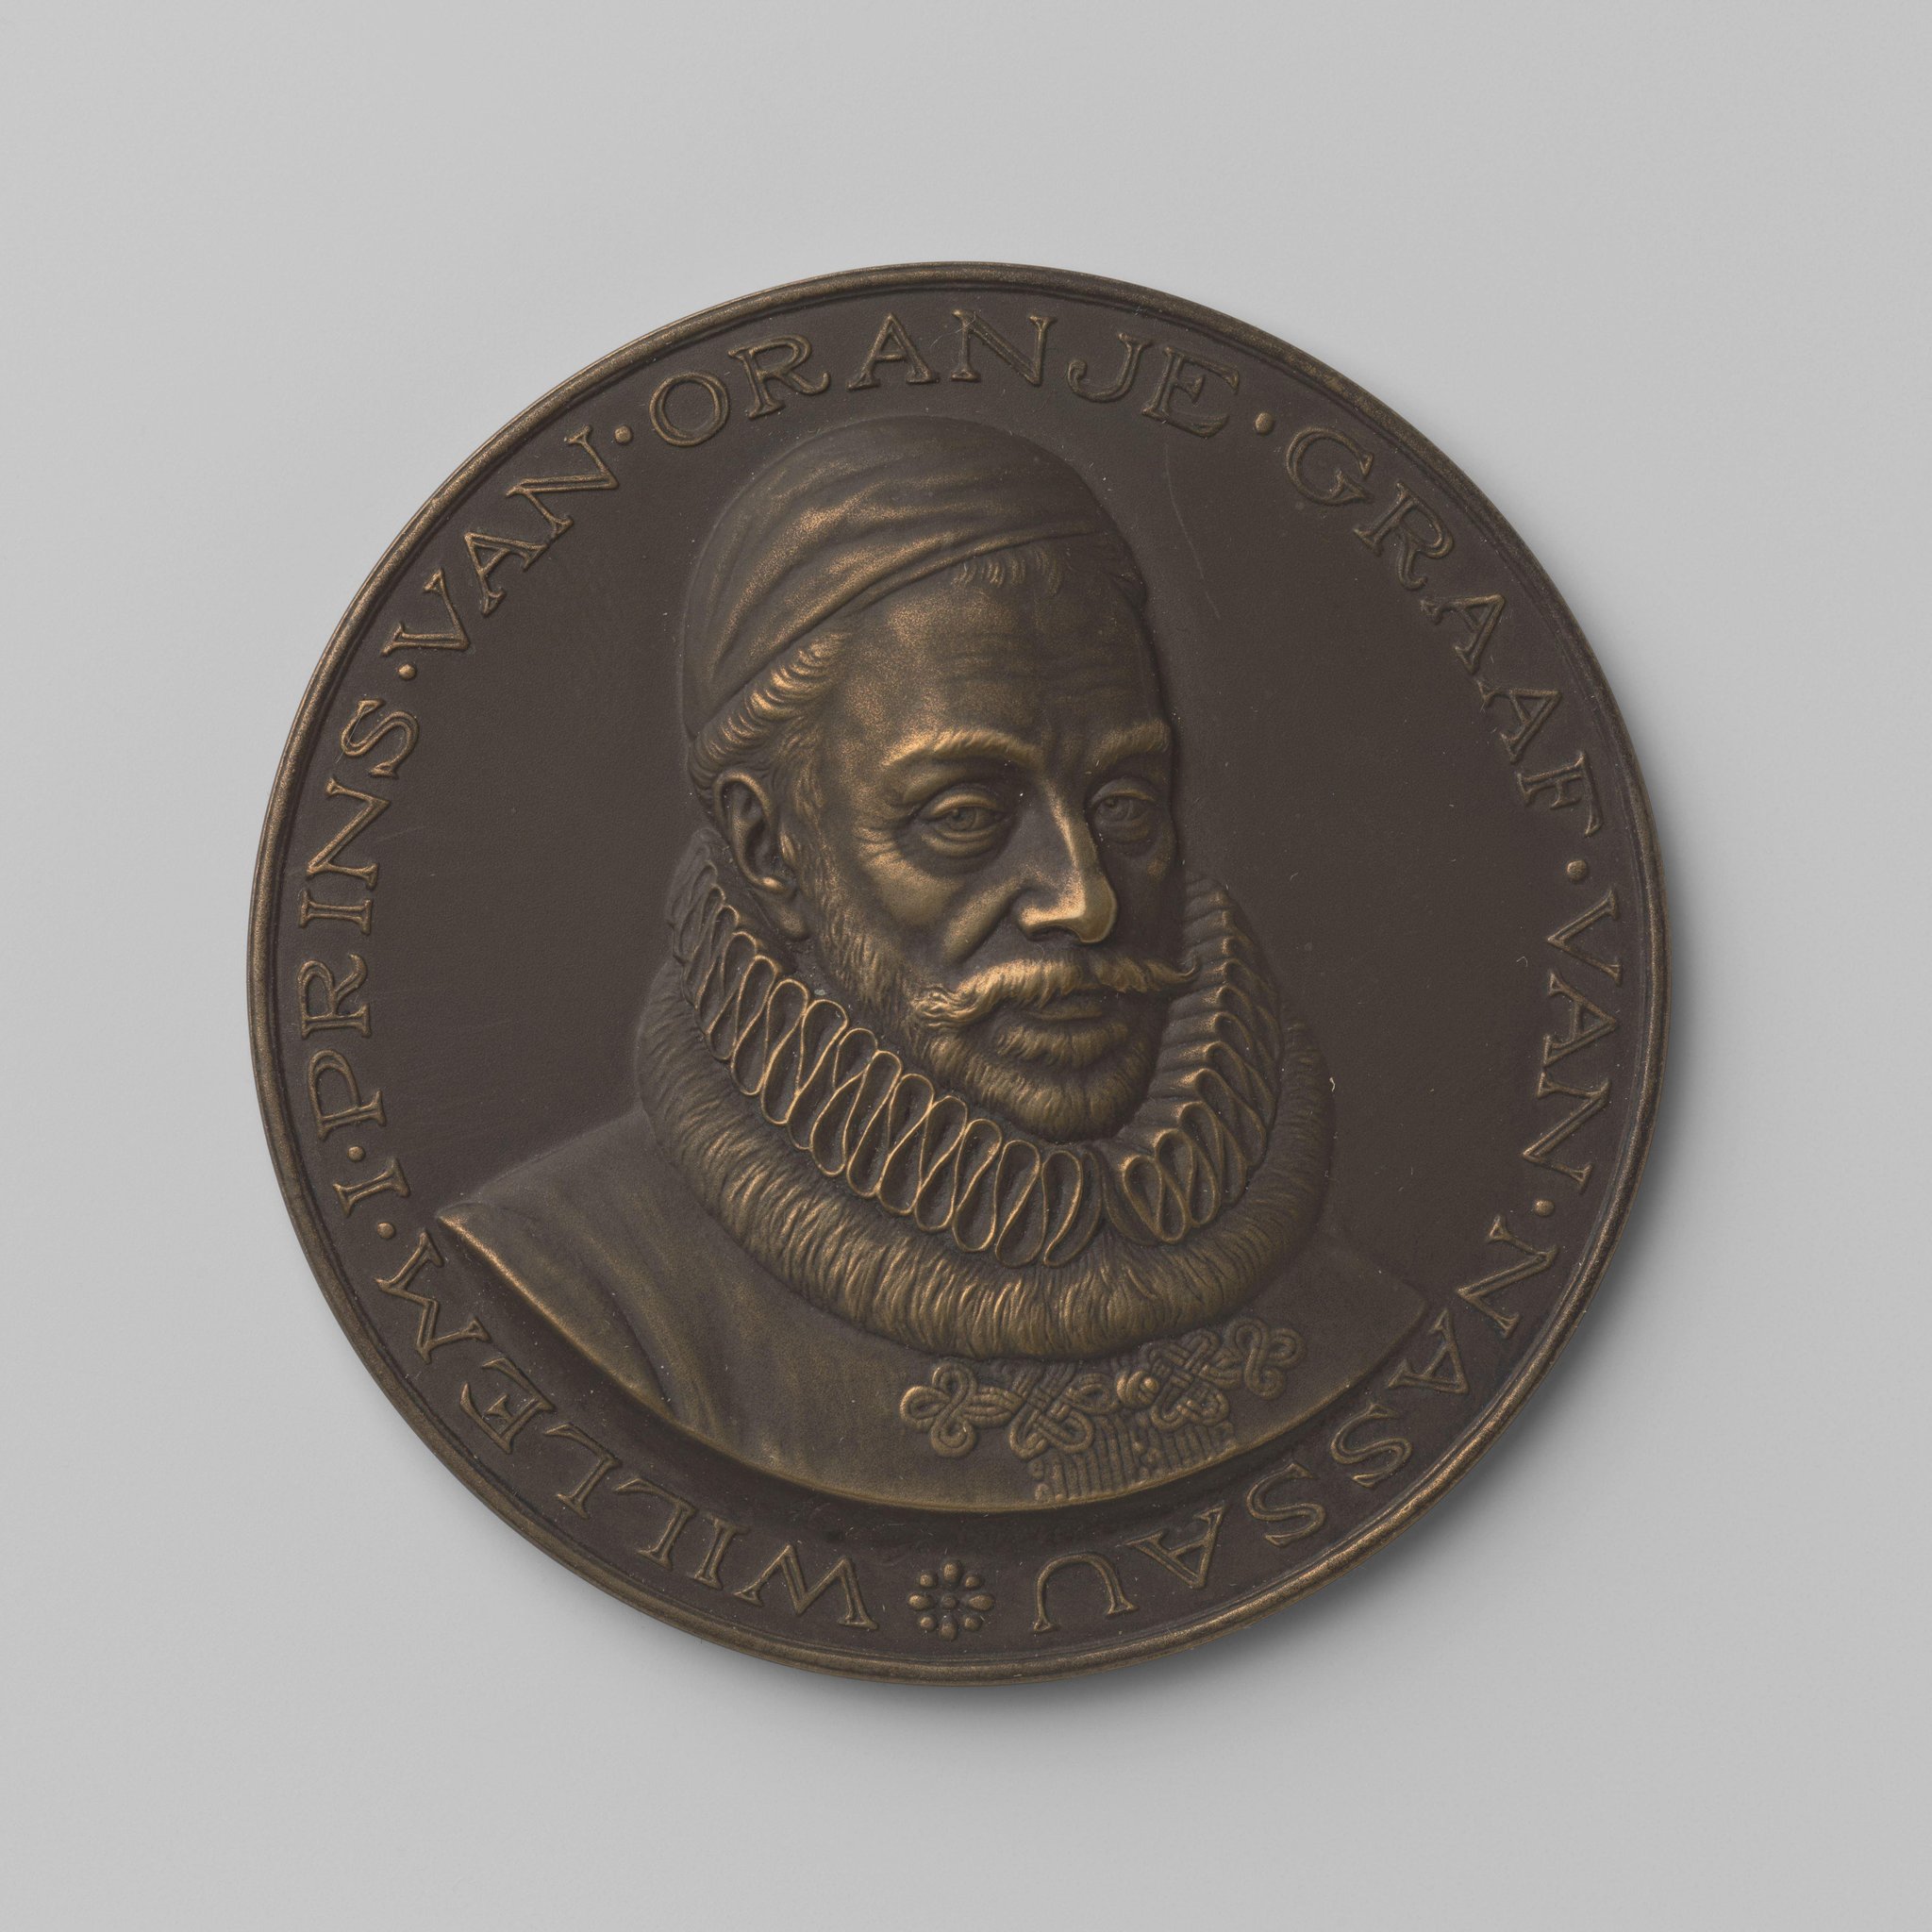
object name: history medal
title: Honderdjarige herdenking van de geboorte van Willem van Oranje 1933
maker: m.p.j. fleur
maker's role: medailleur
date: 1933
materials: bronze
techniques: striking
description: Bronzen penning, op de voorzijde het borstbeeld van Willem van Oranje half naar rechts met omschrift, op de keerzijde een piek met vlag waarop drie regels tekst, met als ondergrond een pijlenbundel.